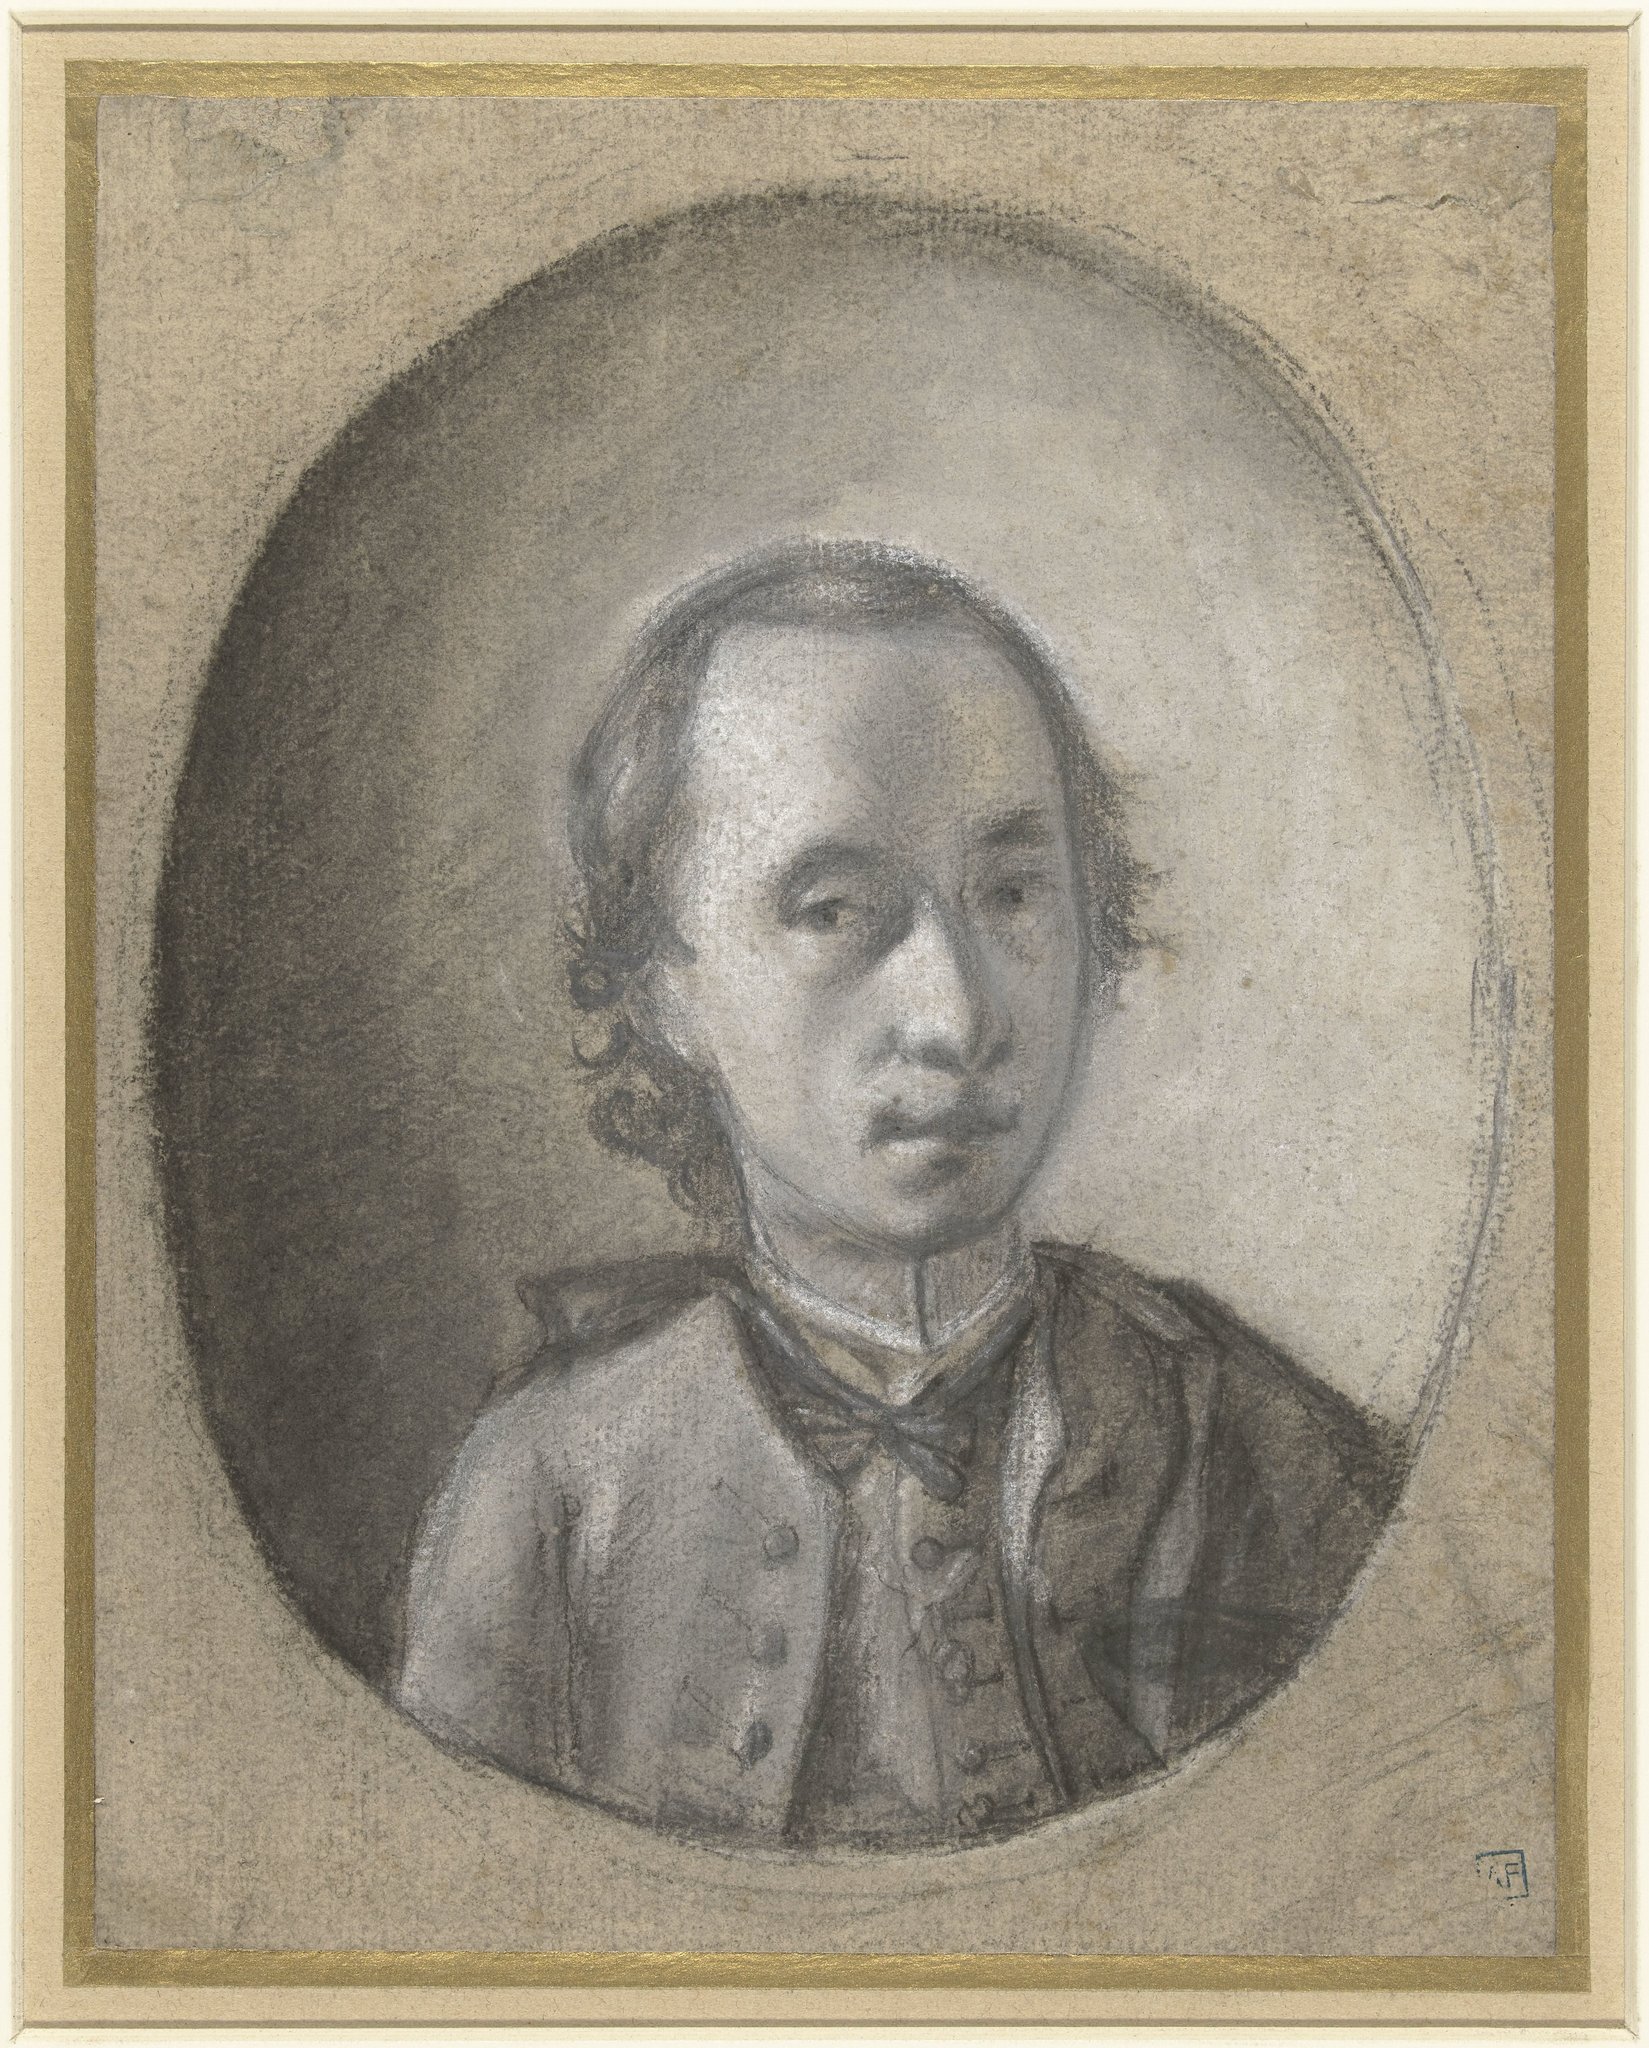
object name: drawing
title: Portret van een Venetiaanse geestelijke, in ovaal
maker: bartolommeo nazari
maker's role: draughtsman, painter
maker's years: 1699-1758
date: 1709-1758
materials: chalk, paper, pencil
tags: anonymous historical person portrayed alone